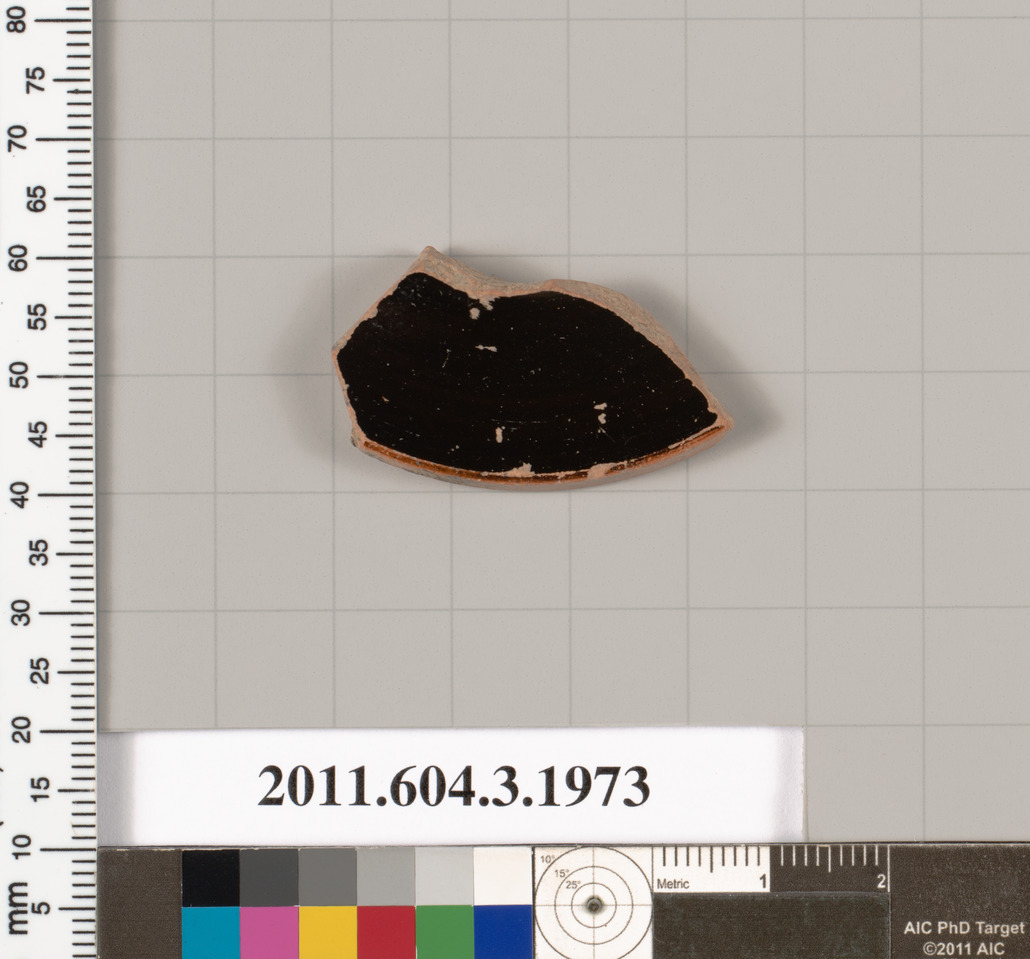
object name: kylix fragment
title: Terracotta fragment of a kylix (drinking cup)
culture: greek, attic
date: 600-501 BCE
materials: terracotta